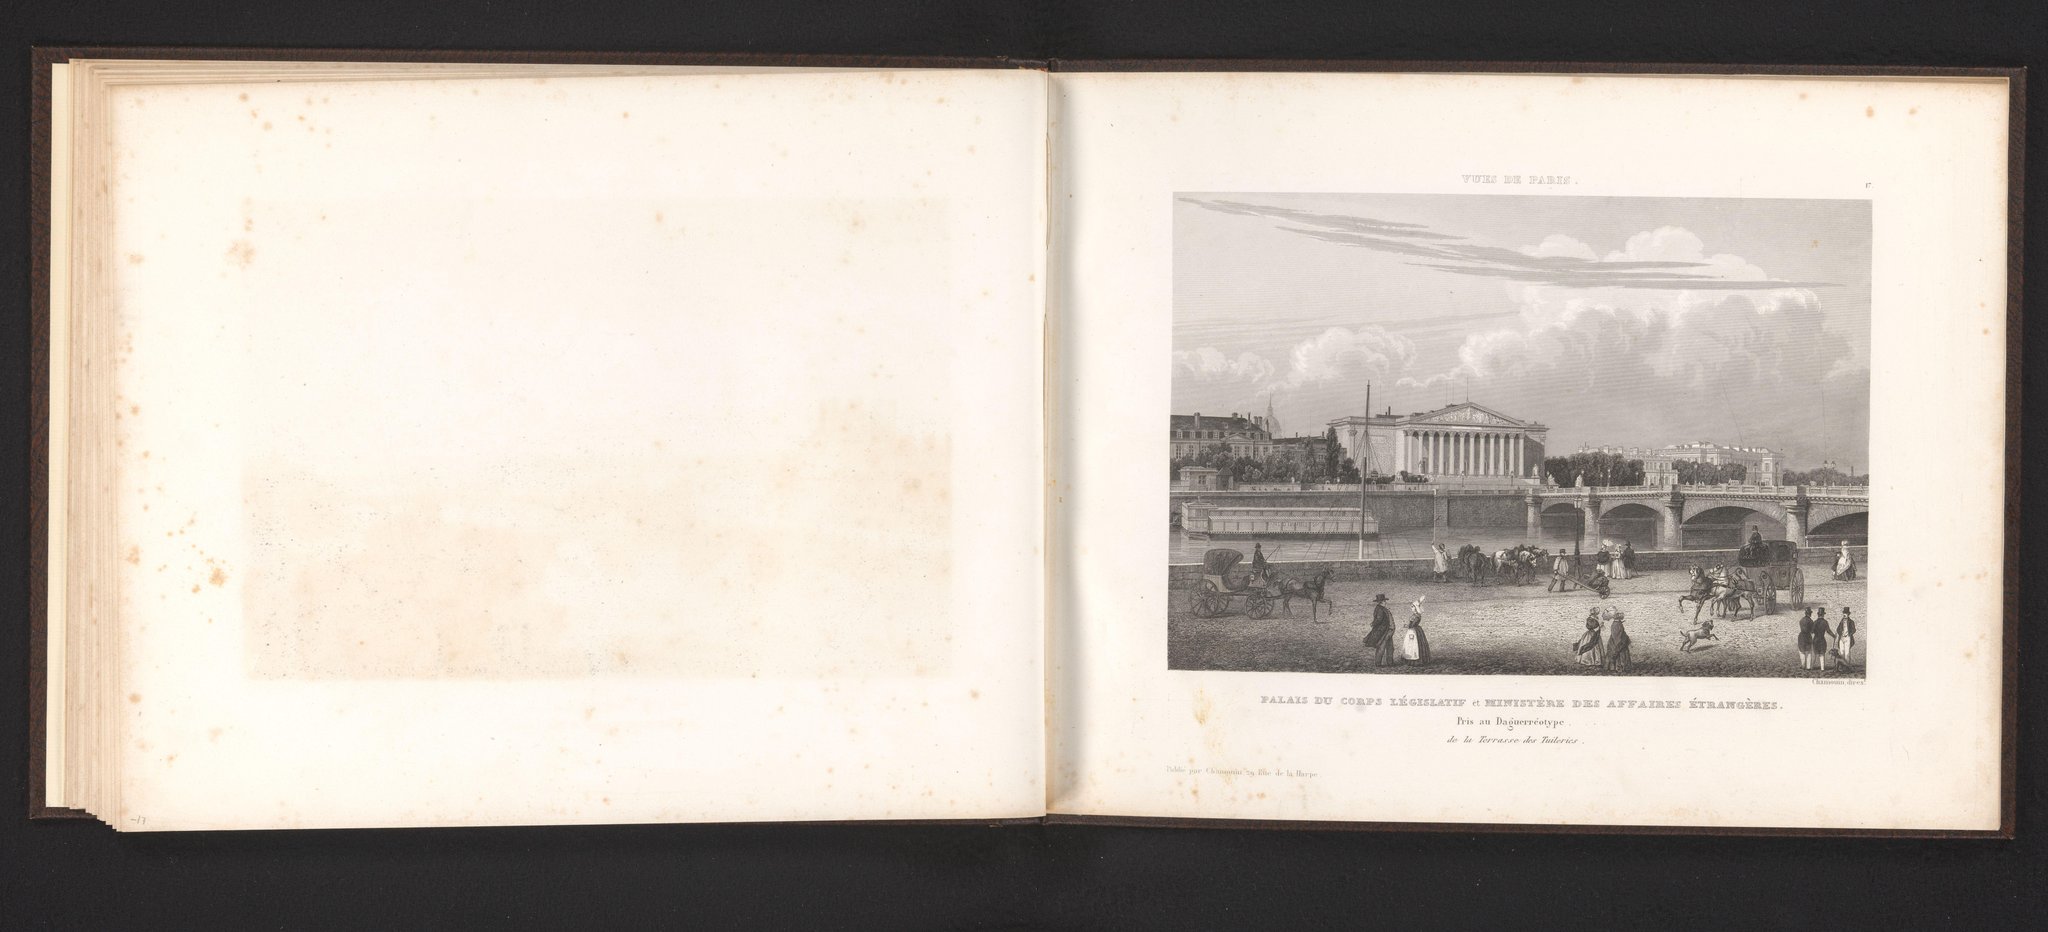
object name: print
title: Palais du corps législatif et ministère des affaires étrangères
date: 1845-1850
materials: paper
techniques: engraving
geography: paris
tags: governmental and representative bodies, palace, paris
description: Prent op achttiende ongenummerde pagina na titelpagina. Prent gemaakt naar daguerreotypie.